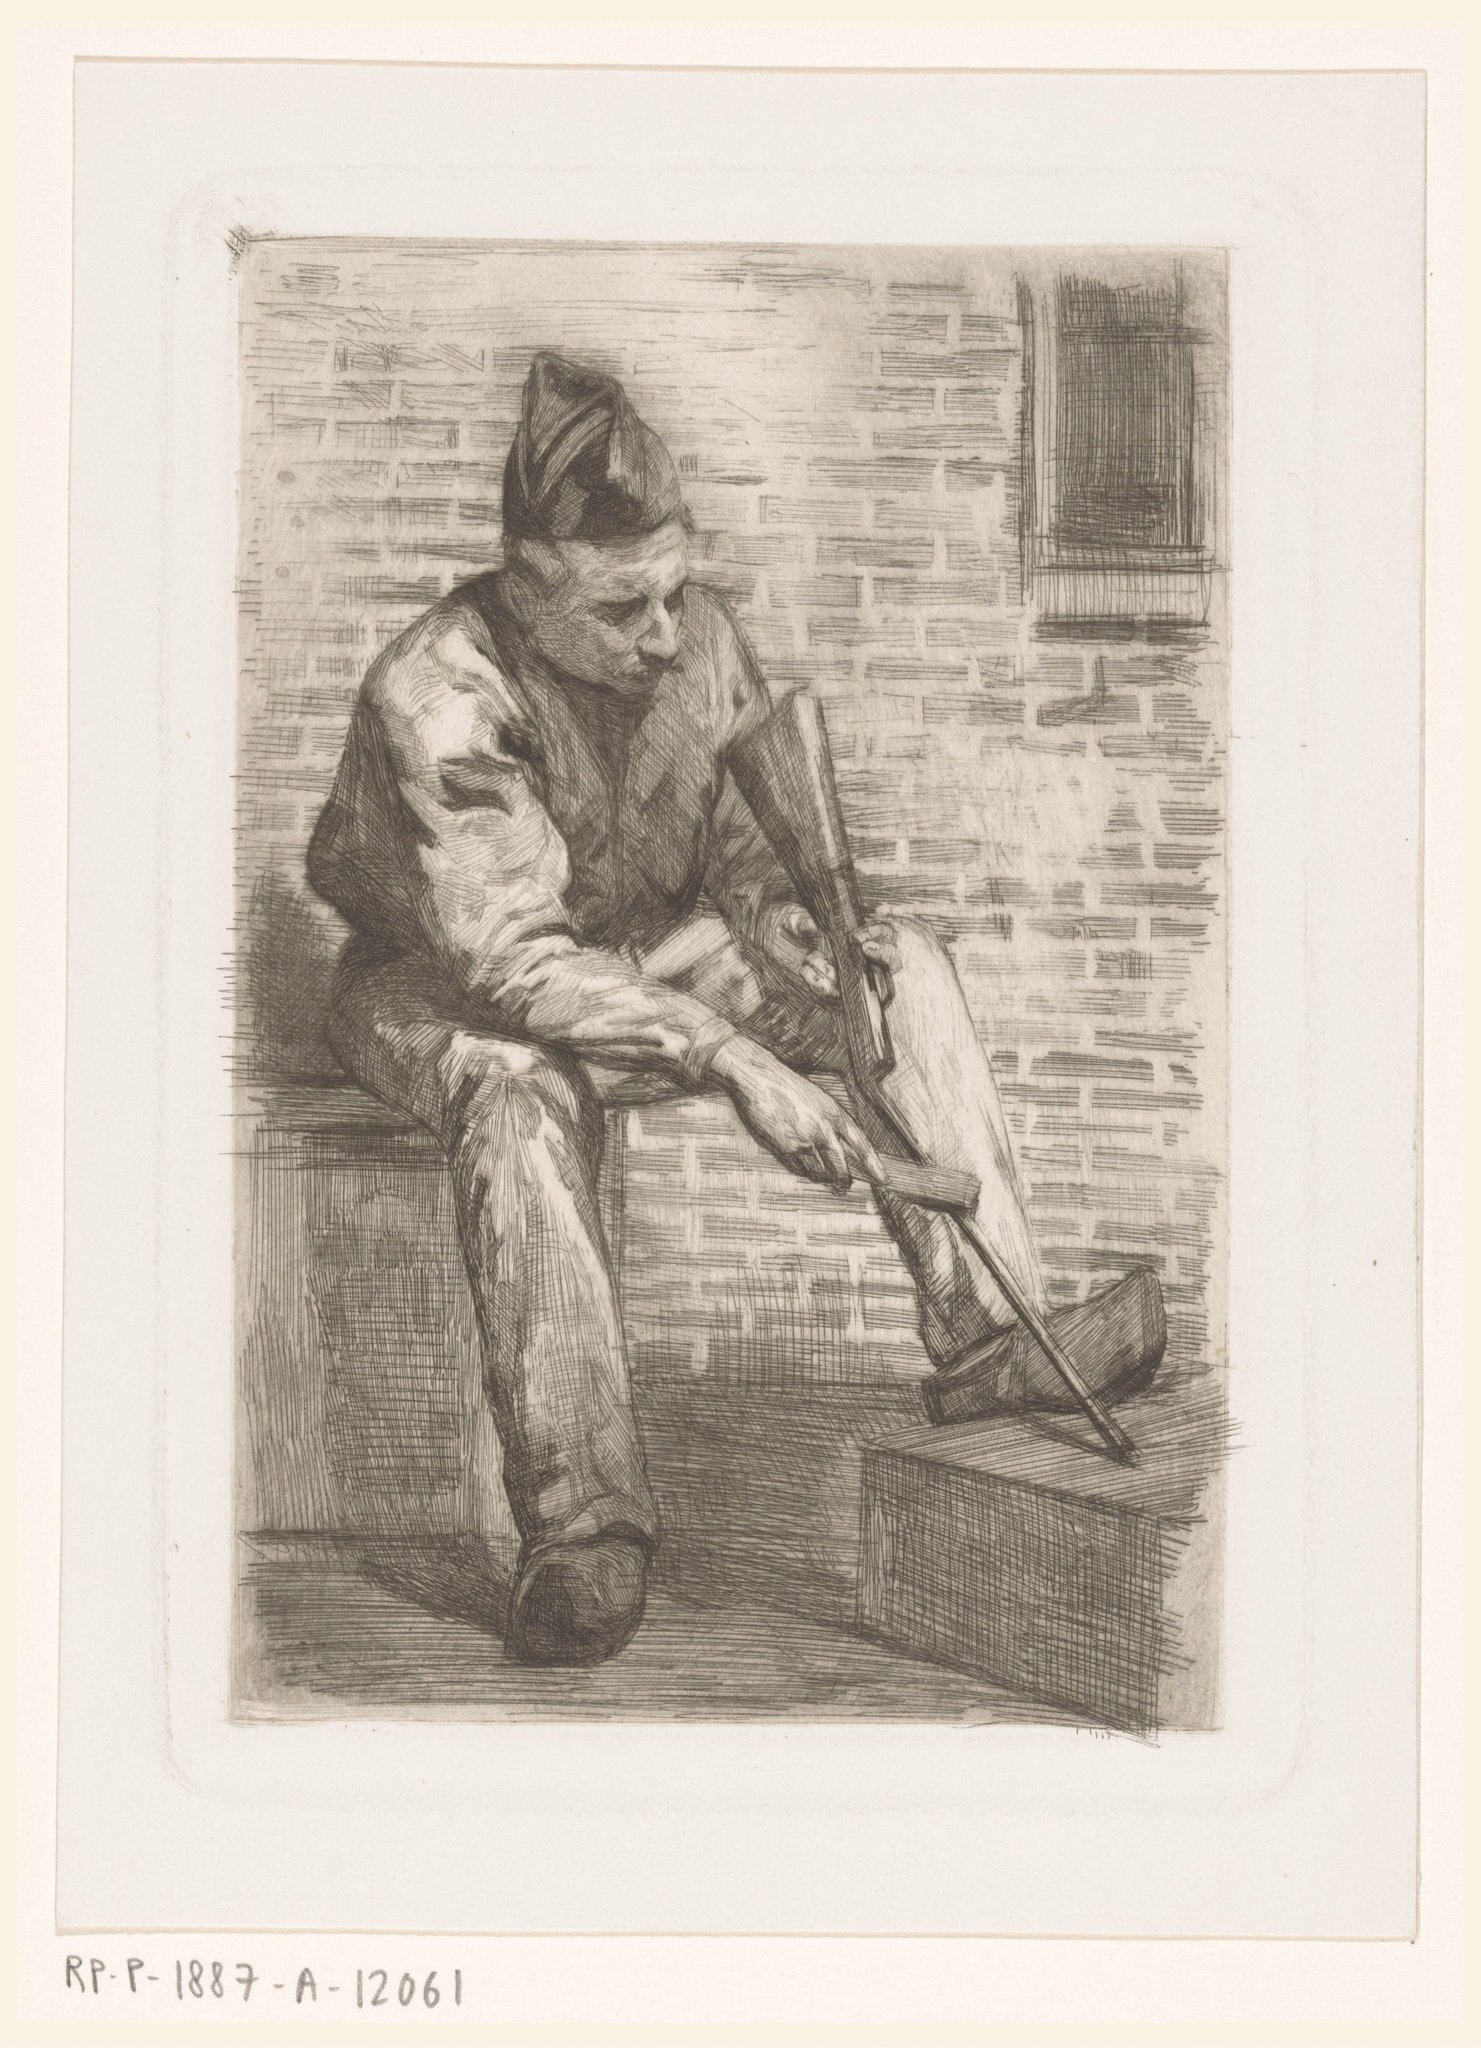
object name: print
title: Soldaat die zijn geweer schoonmaakt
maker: heinrich m. krabbé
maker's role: draughtsman, print maker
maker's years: 1868-1931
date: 1878-1887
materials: paper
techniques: etching, intaglio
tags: private soldier, firearms: rifle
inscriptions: collector's mark: Lugt 2228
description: De soldaat zit op een bank voor een gebouw. Rechtsboven een gedeelte van een venster. De soldaat houdt het geweer met zijn hand vast, terwijl hij met een borstel de loop van het geweer poetst.